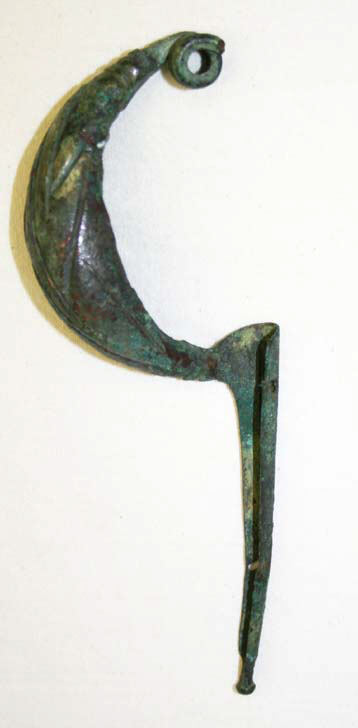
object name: pin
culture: european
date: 400-301 BCE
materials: bronze